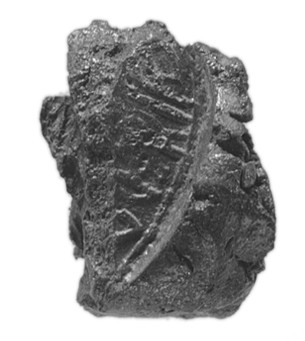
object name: sealing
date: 2030-1640 BCE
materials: clay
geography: egypt